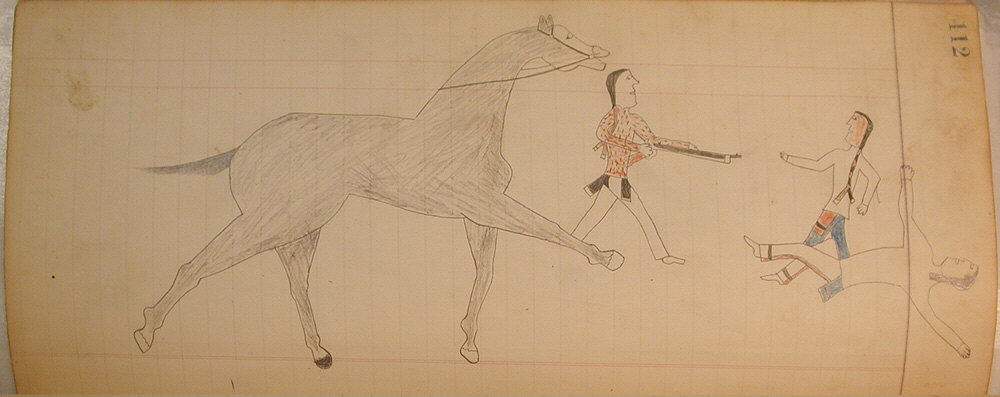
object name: drawing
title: Maffet Ledger: Drawing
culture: cheyenne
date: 1874-1881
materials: crayon, graphite, paper, watercolor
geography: united states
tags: firearms,men,horses